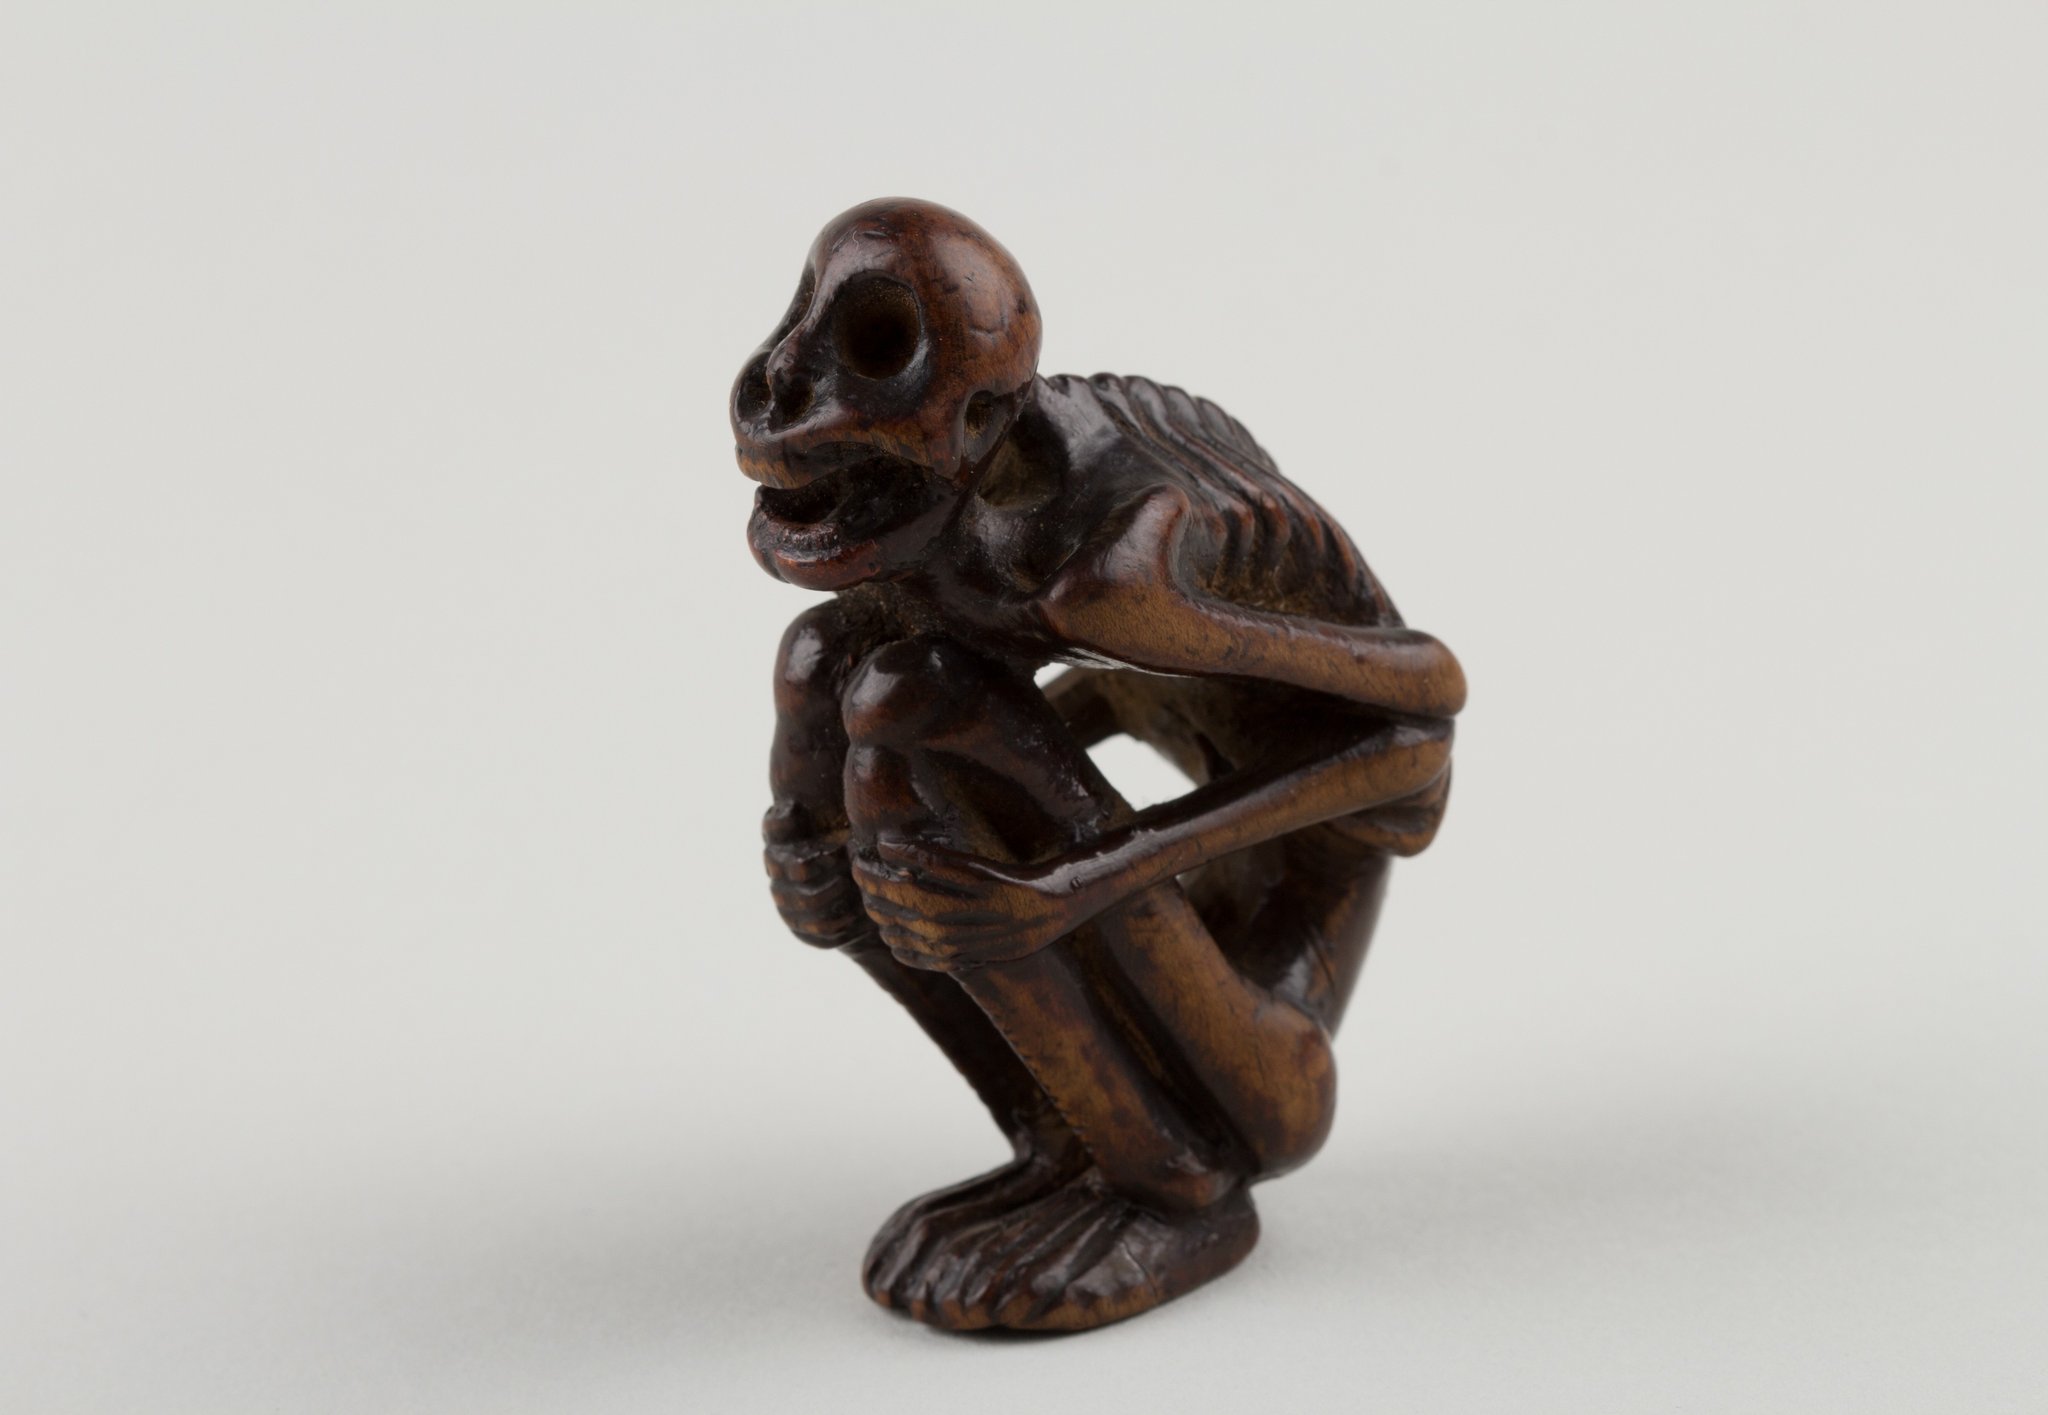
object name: netsuke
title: Netsuke of Crouching Figure of a Skeleton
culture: japanese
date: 1801-1900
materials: wood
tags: skeletons